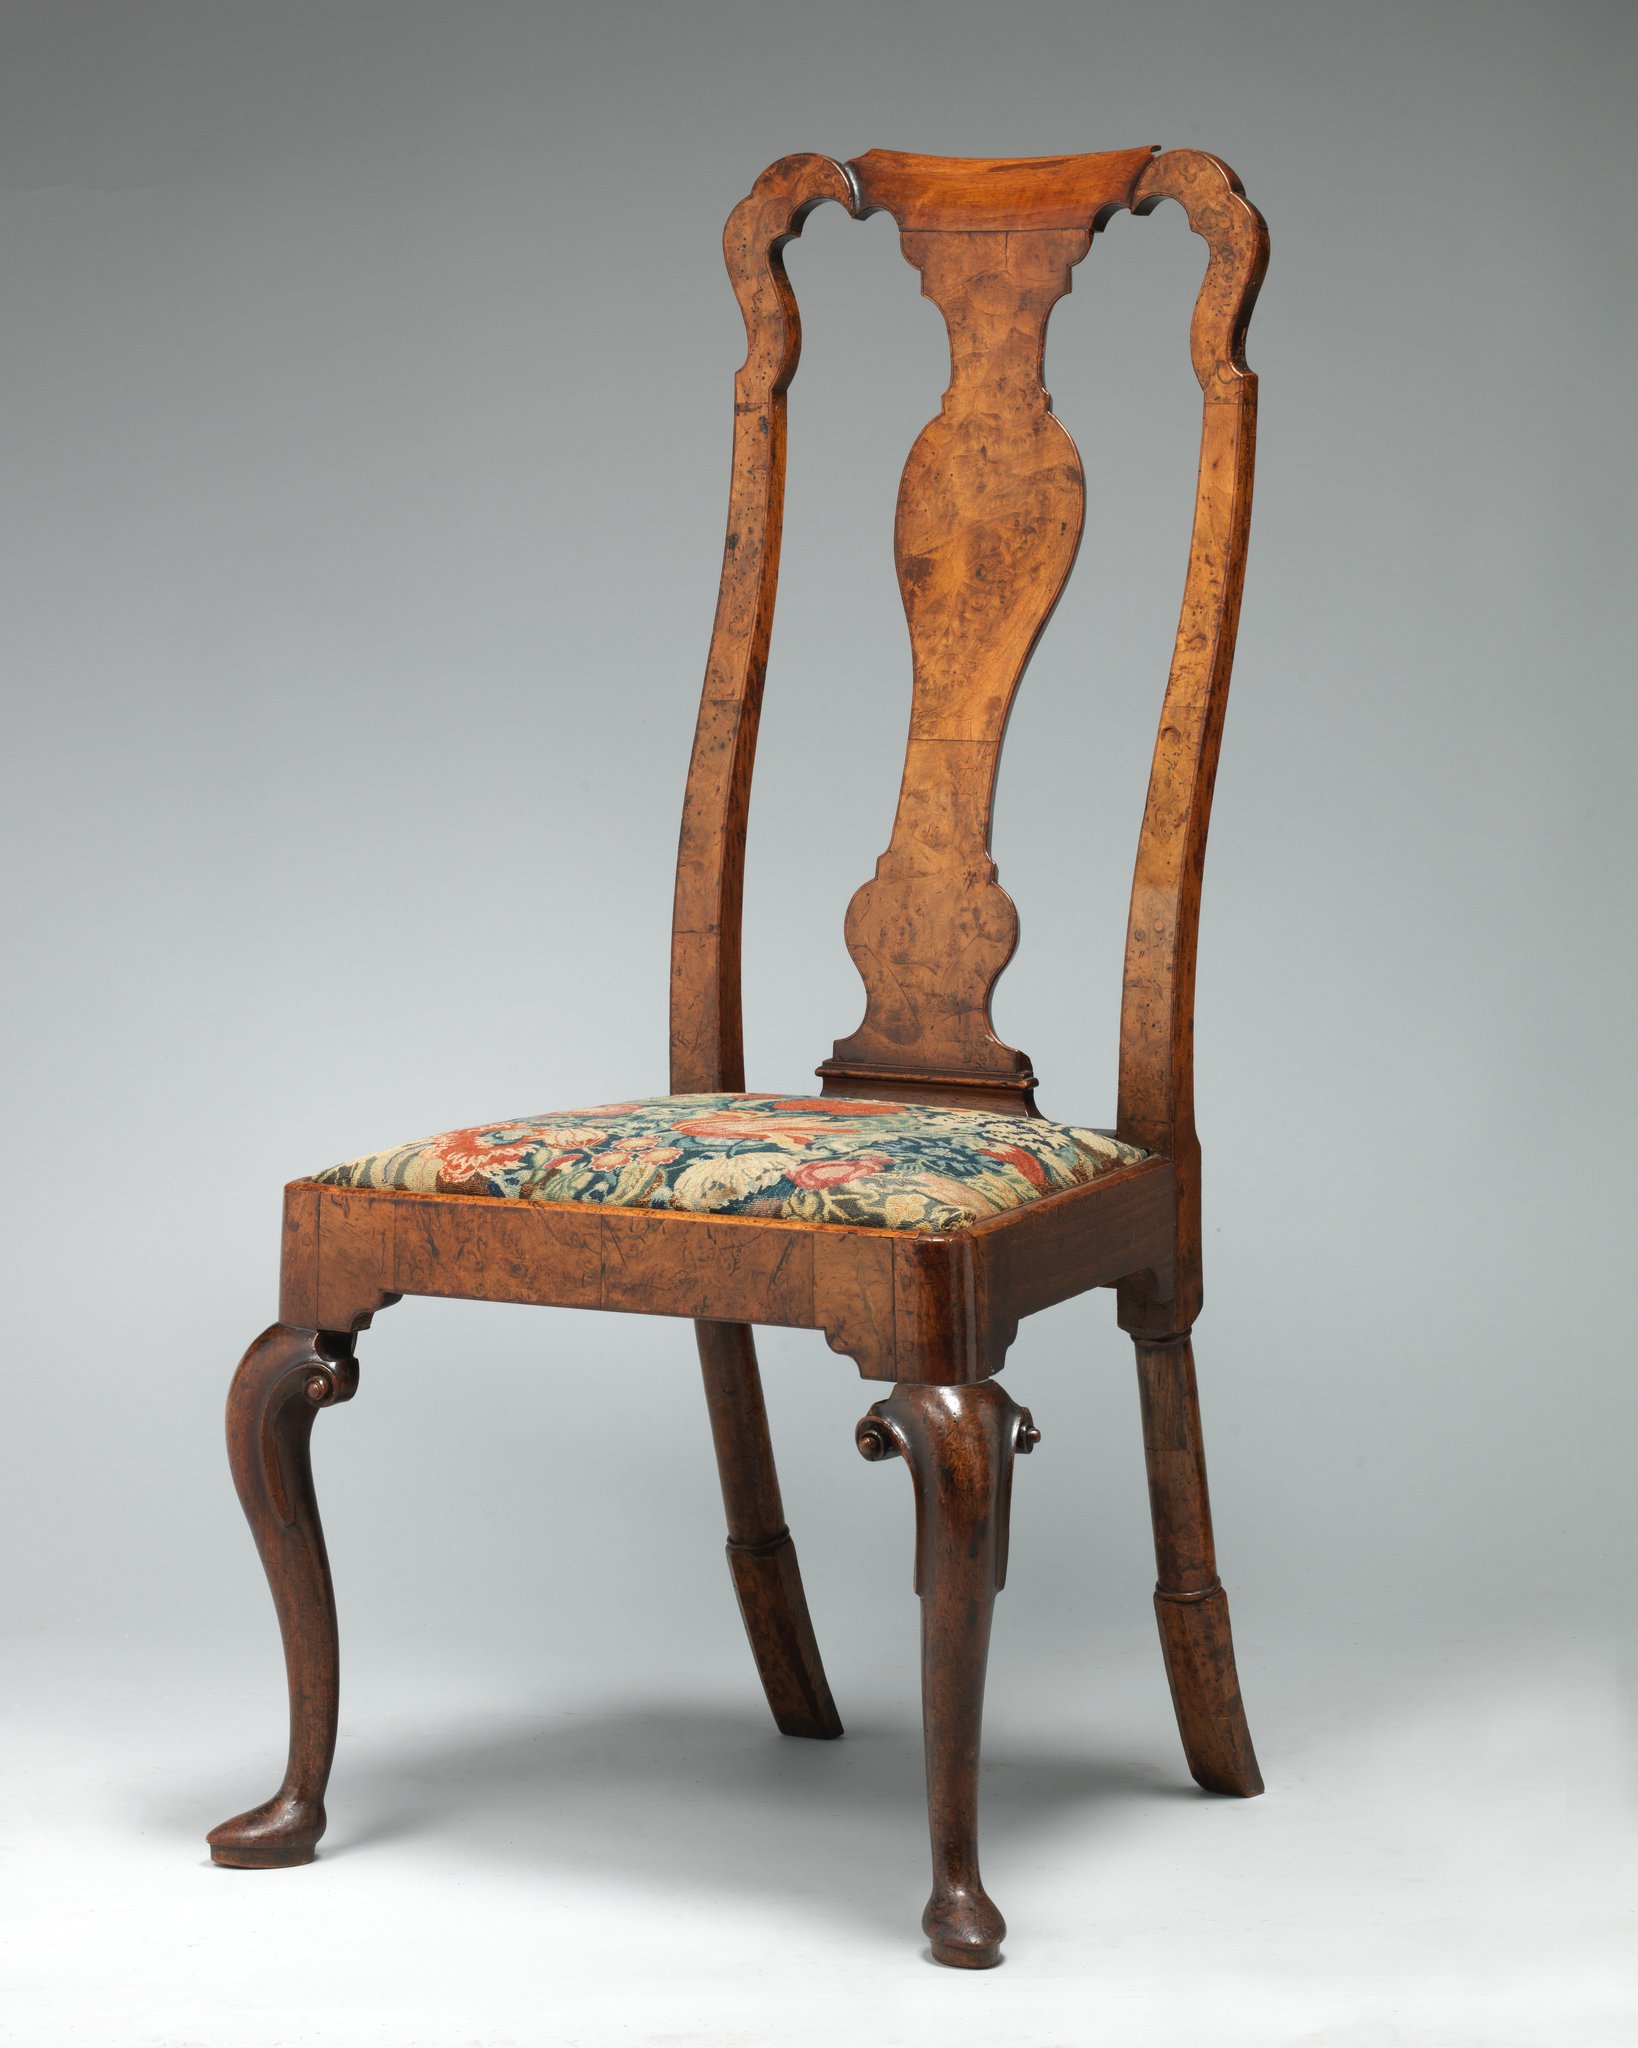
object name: side chair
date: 1710-1720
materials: wood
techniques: veneering